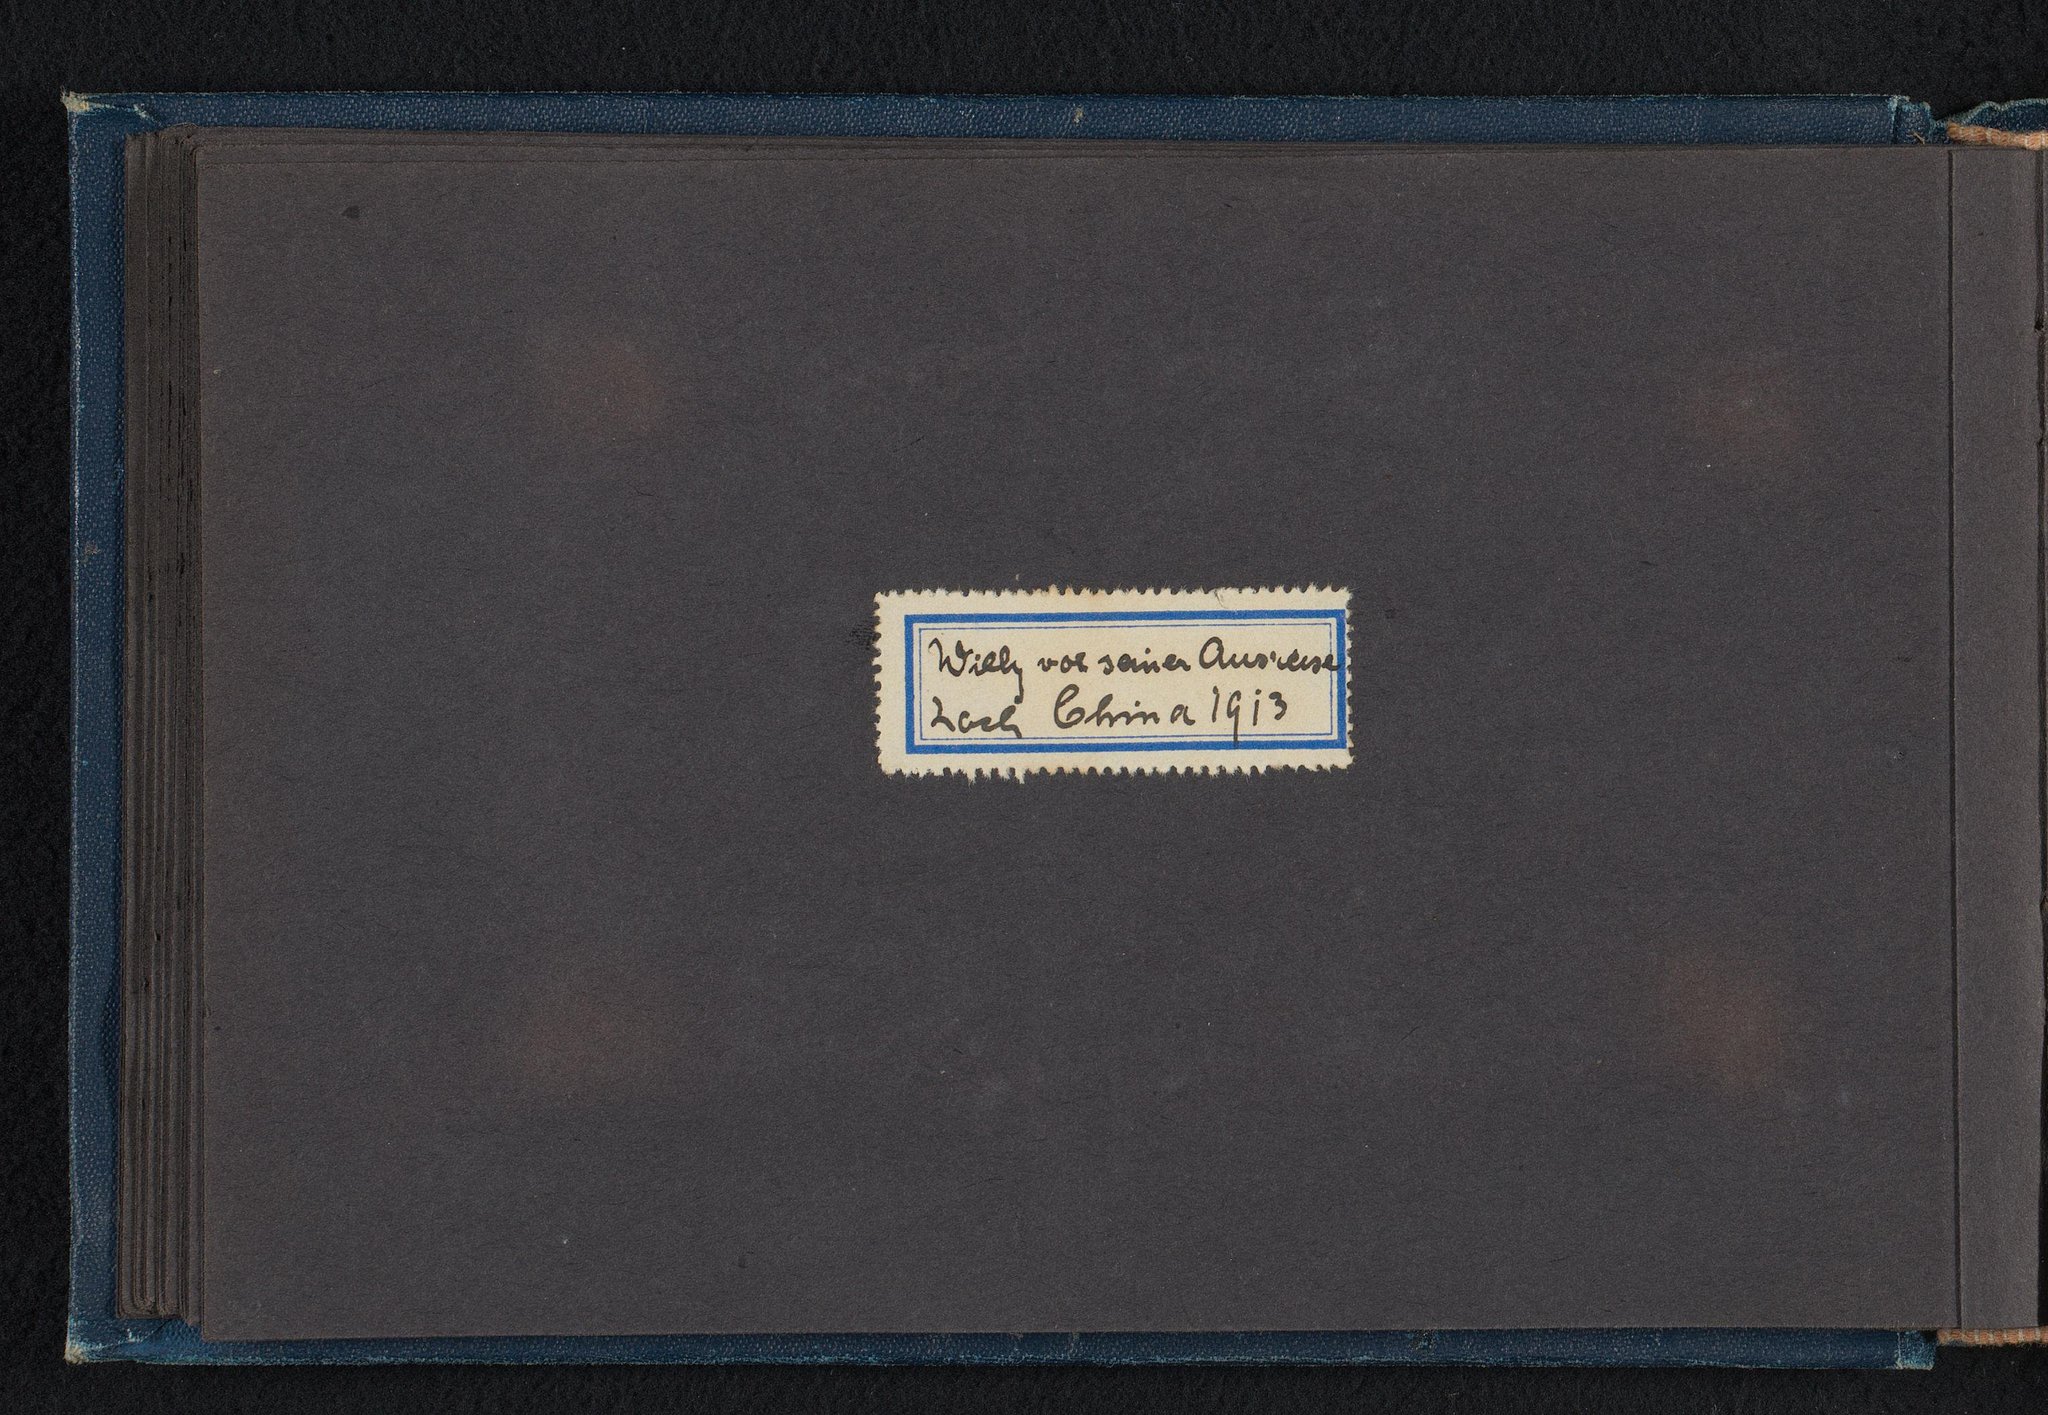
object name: album leaf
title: Voor Willy's reis naar China 1913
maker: else wachenheimer-moos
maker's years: 1895-1944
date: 1913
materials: paper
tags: else wachenheimer-moos, willy moos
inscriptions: inscription: ‘Willy vor seiner Ausreise nach China 1913’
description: Albumblad zonder foto, alleen een etiket met opschrift. Onderdeel van het fotoalbum van Else Wachenheimer-Moos en haar broers Arthur en Willy Moos en anderen in de periode 1913-1918.